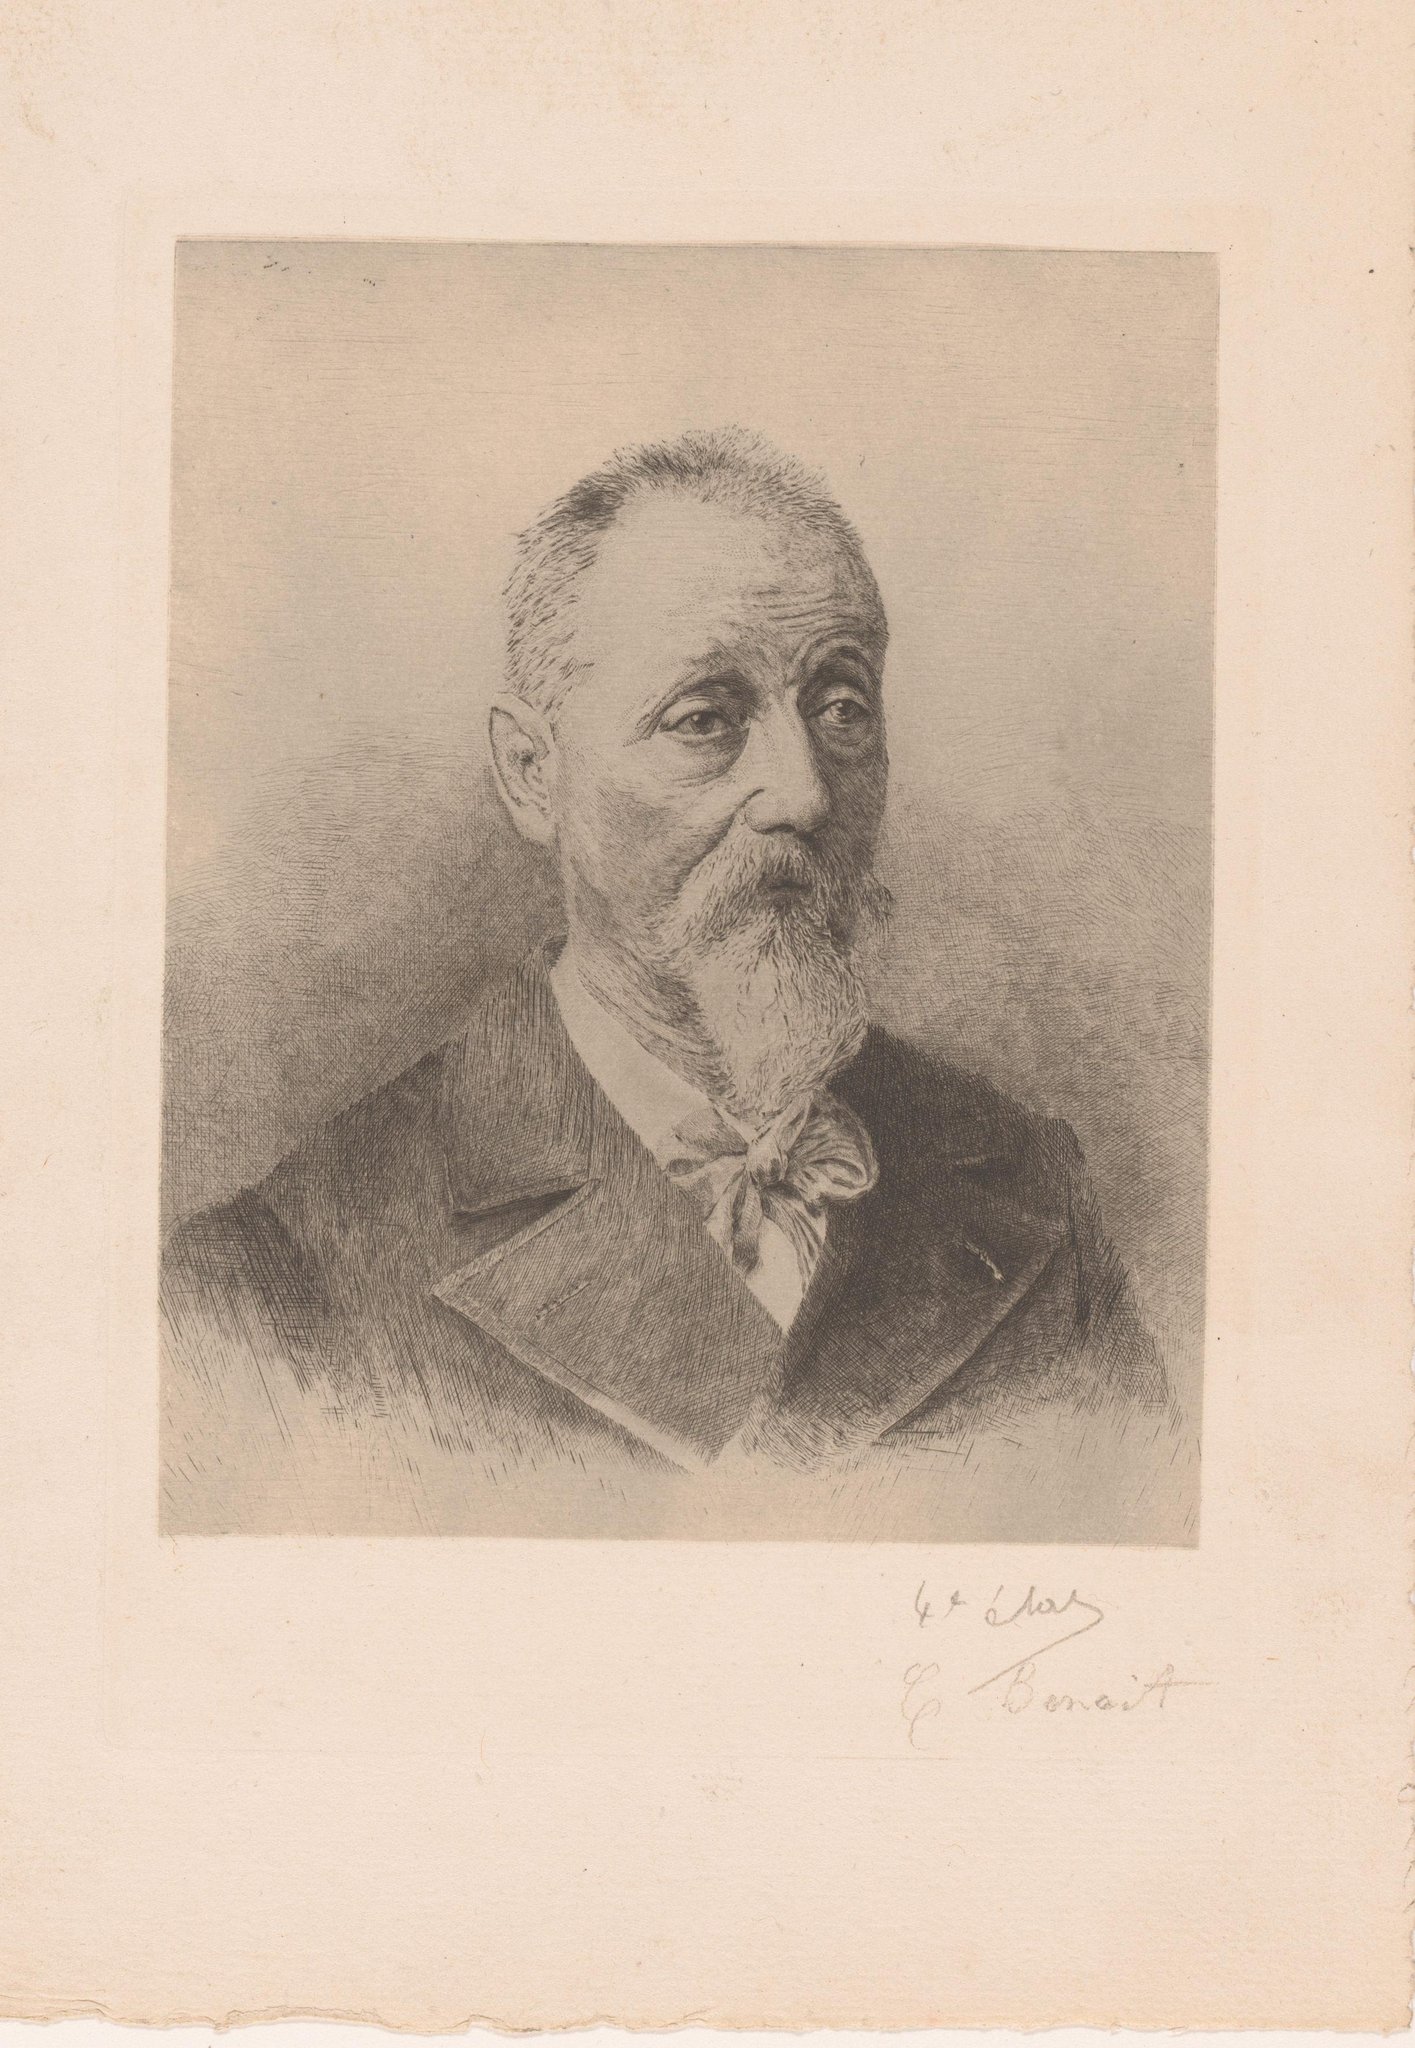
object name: print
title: Portret van een onbekende oudere man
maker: clément benoit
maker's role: draughtsman, painter, print maker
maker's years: 1866-1953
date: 1876-1909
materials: paper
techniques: etching, intaglio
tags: historical persons, old man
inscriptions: collector's mark: Lugt 2228